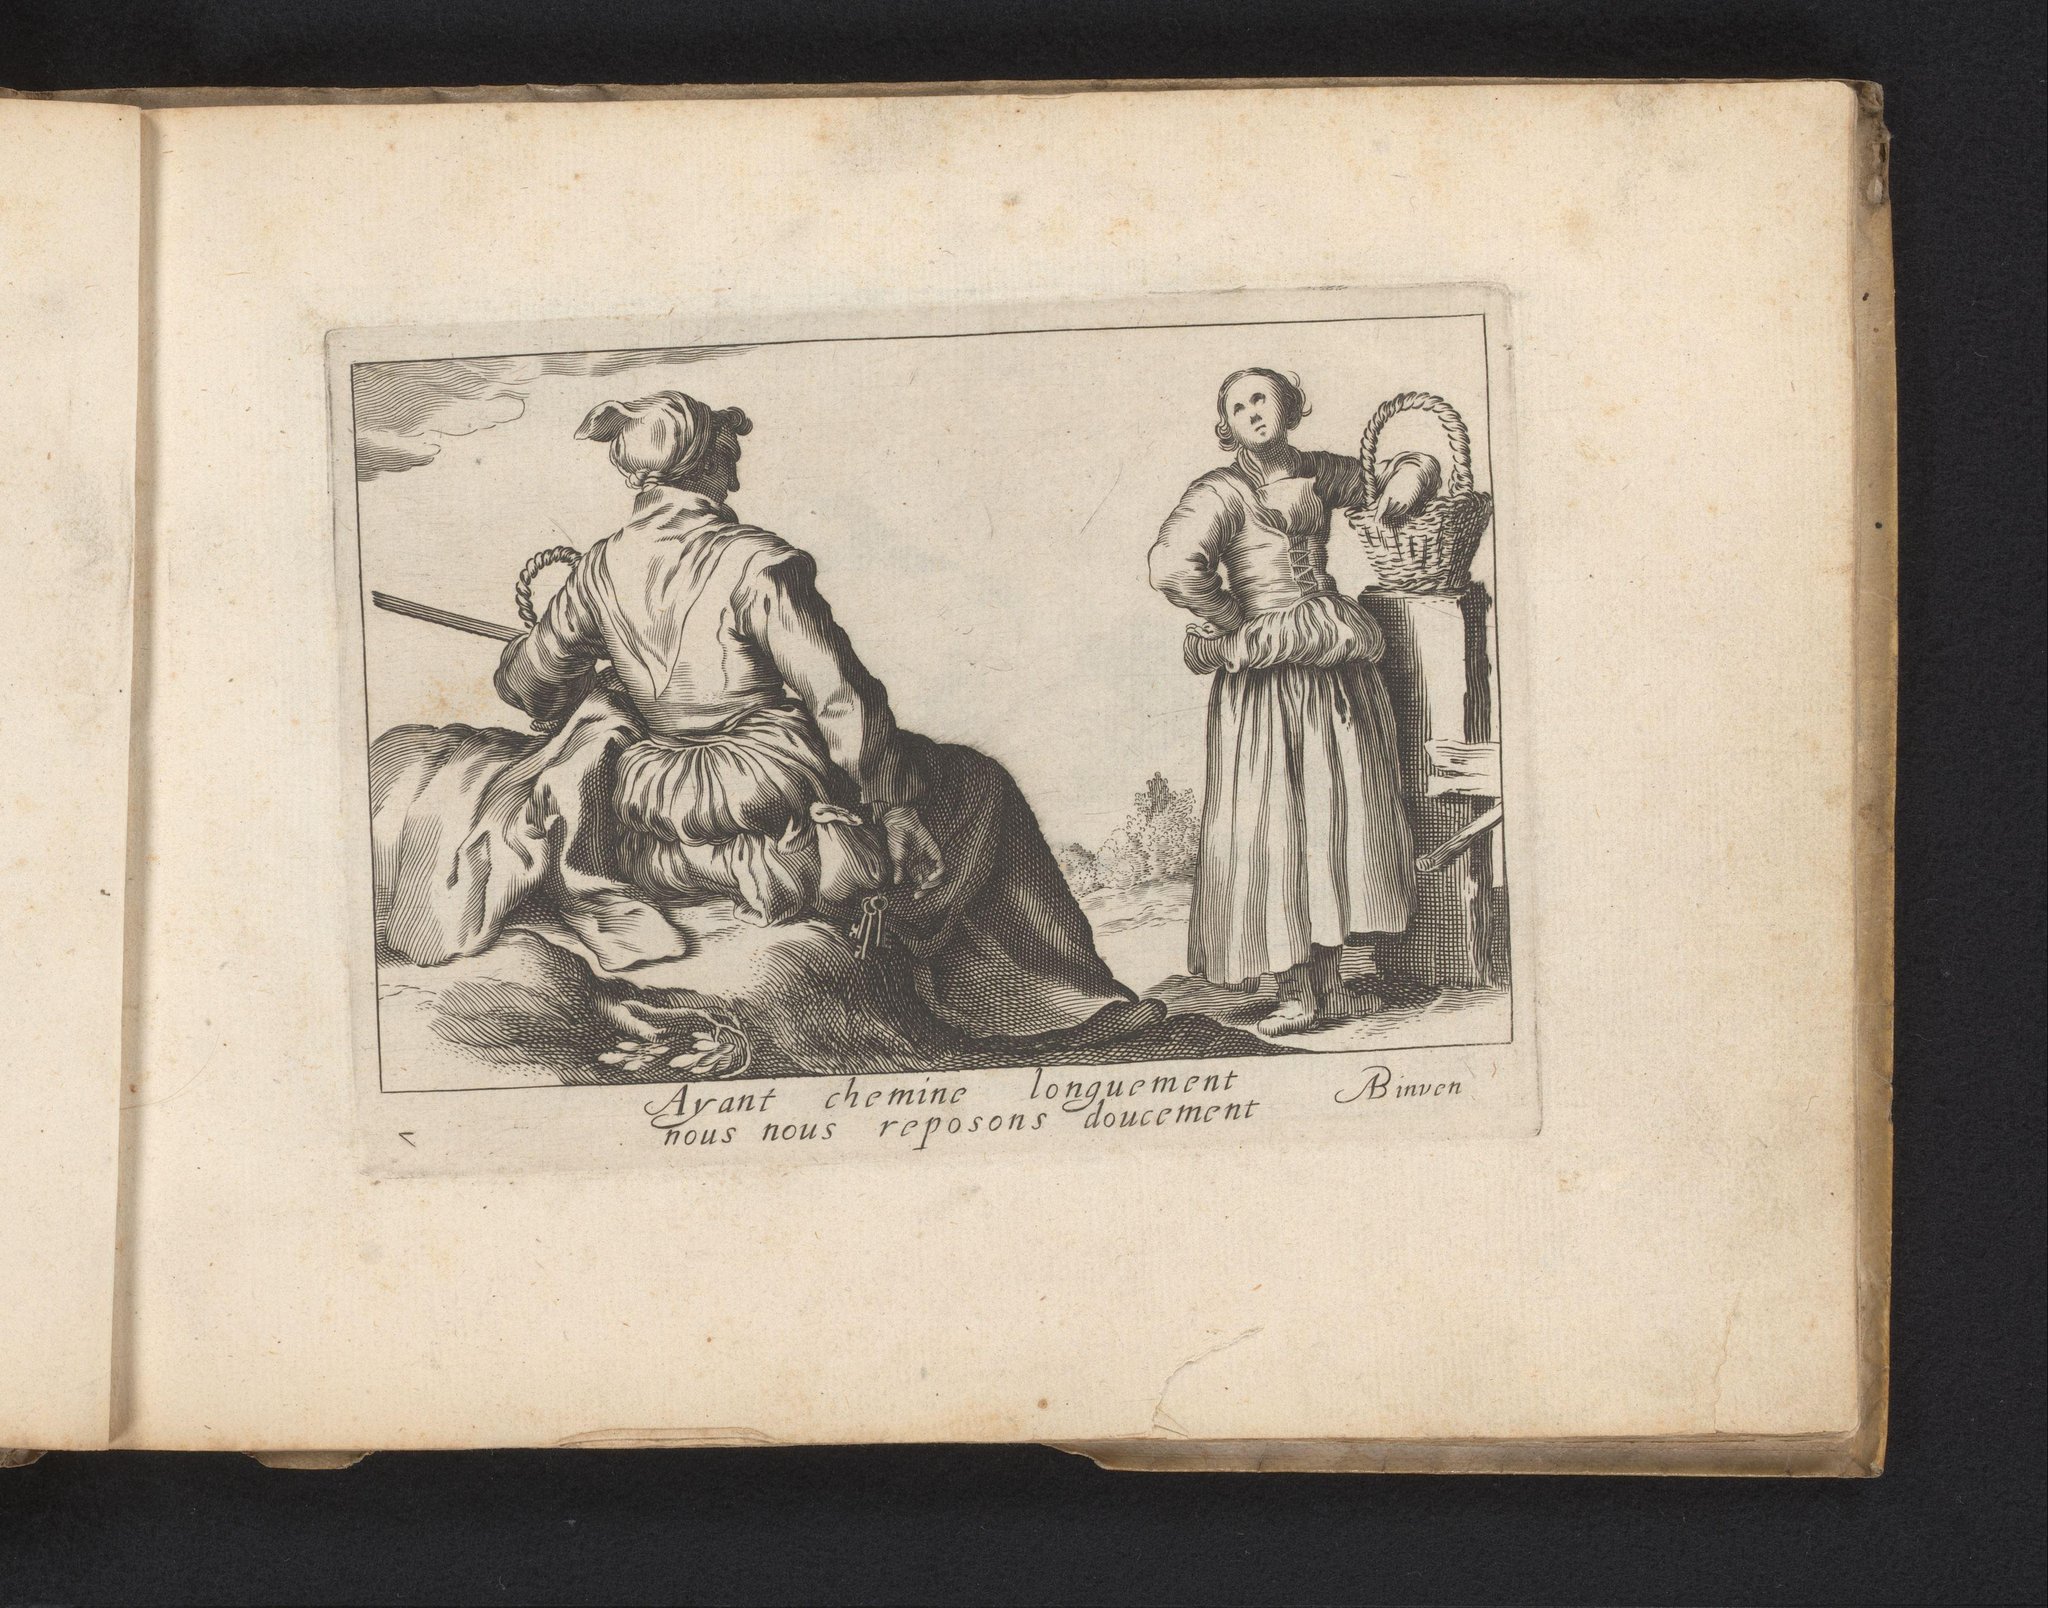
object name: album leaf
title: Figuren in landschappen naar Bloemaert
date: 1600-1650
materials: paper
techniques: etching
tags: (traveller) resting in the open air, old woman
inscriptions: collector's mark: ‘Bibliotheek/ Rijksmuseum/ Amsterdam’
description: Deze prent maakt deel uit van een album.